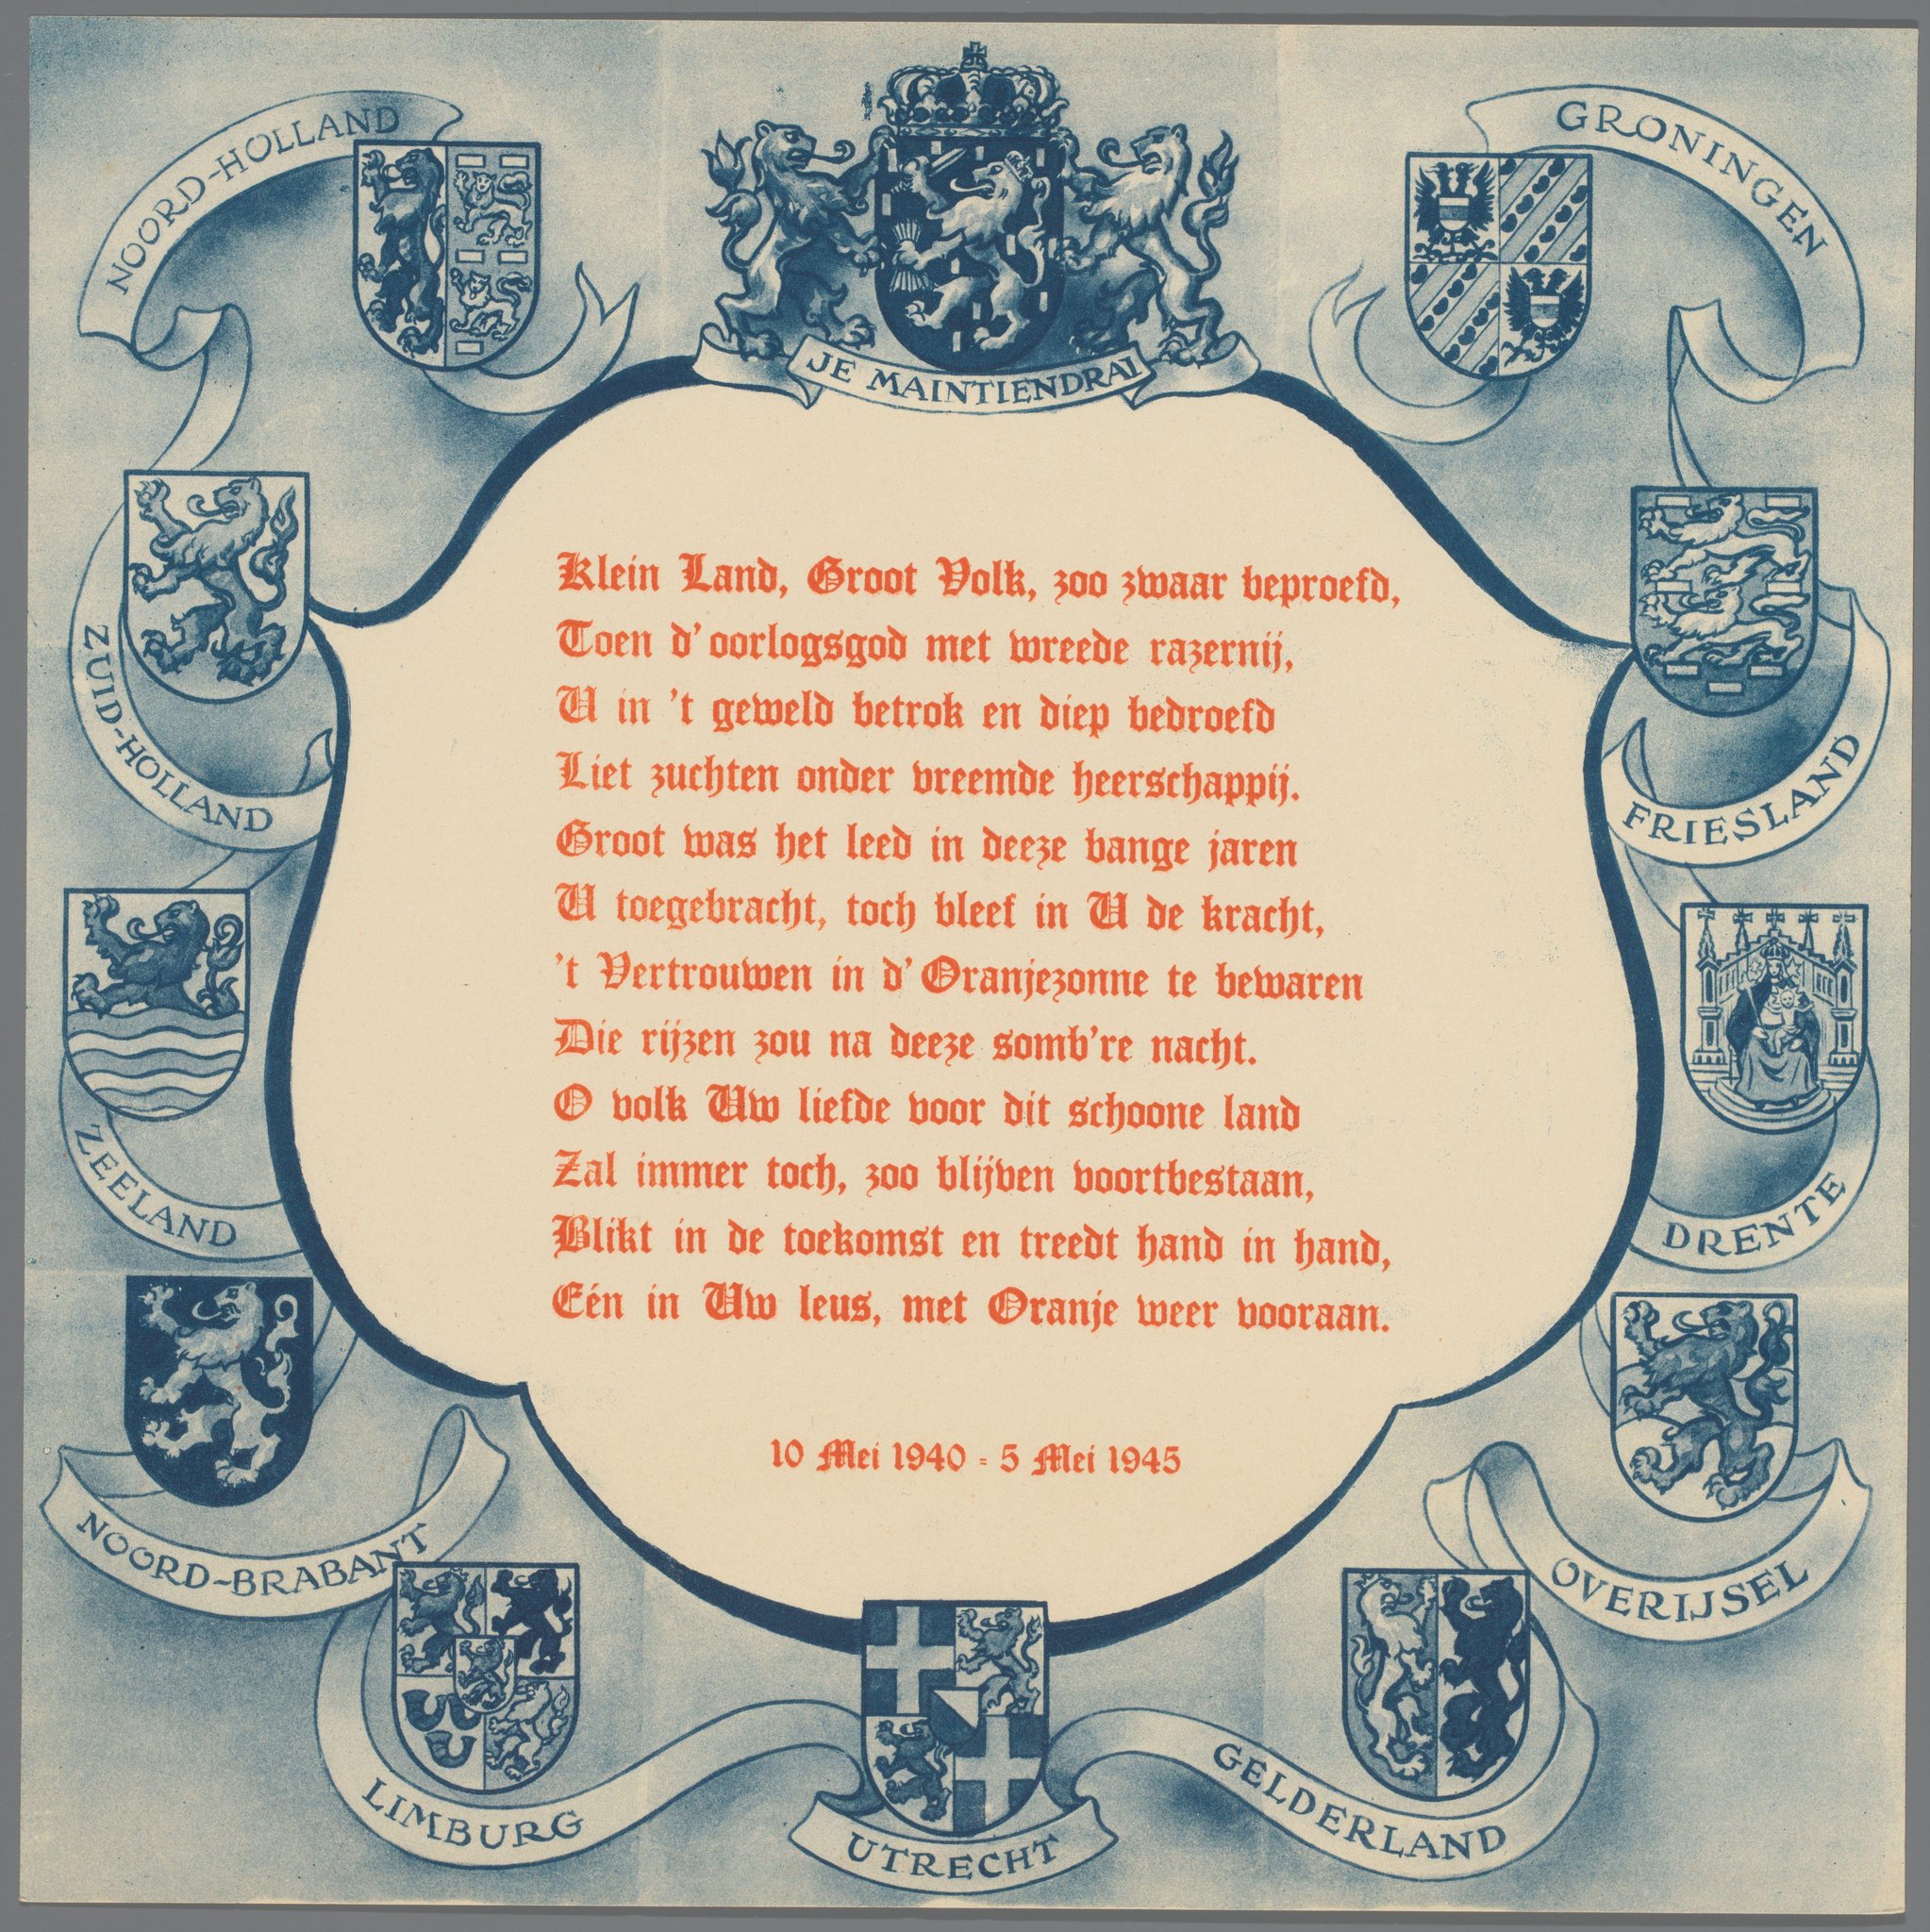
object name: print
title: Gedicht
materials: ink, paper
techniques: printing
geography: rotterdam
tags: netherlands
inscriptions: inscription: ‘Wapen van Nederland en de elf provinciën’, date: ‘10 mei 1945 - 5 mei 1945’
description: Rijmprent ter gelegenheid van de bevrijding van Nederland, 6 mei 1945. Gedicht met oranje, gothische letters op een wit kader, met rondom het wapen van Nederland in blauwe linten en de wapens van de elf provincies met elkaar verbonden door een lint, waarop de namen van de provincie apart geschreven staan. Eerste regel: 'Klein Land, Groot Volk, zoo zwaar beproefd'.